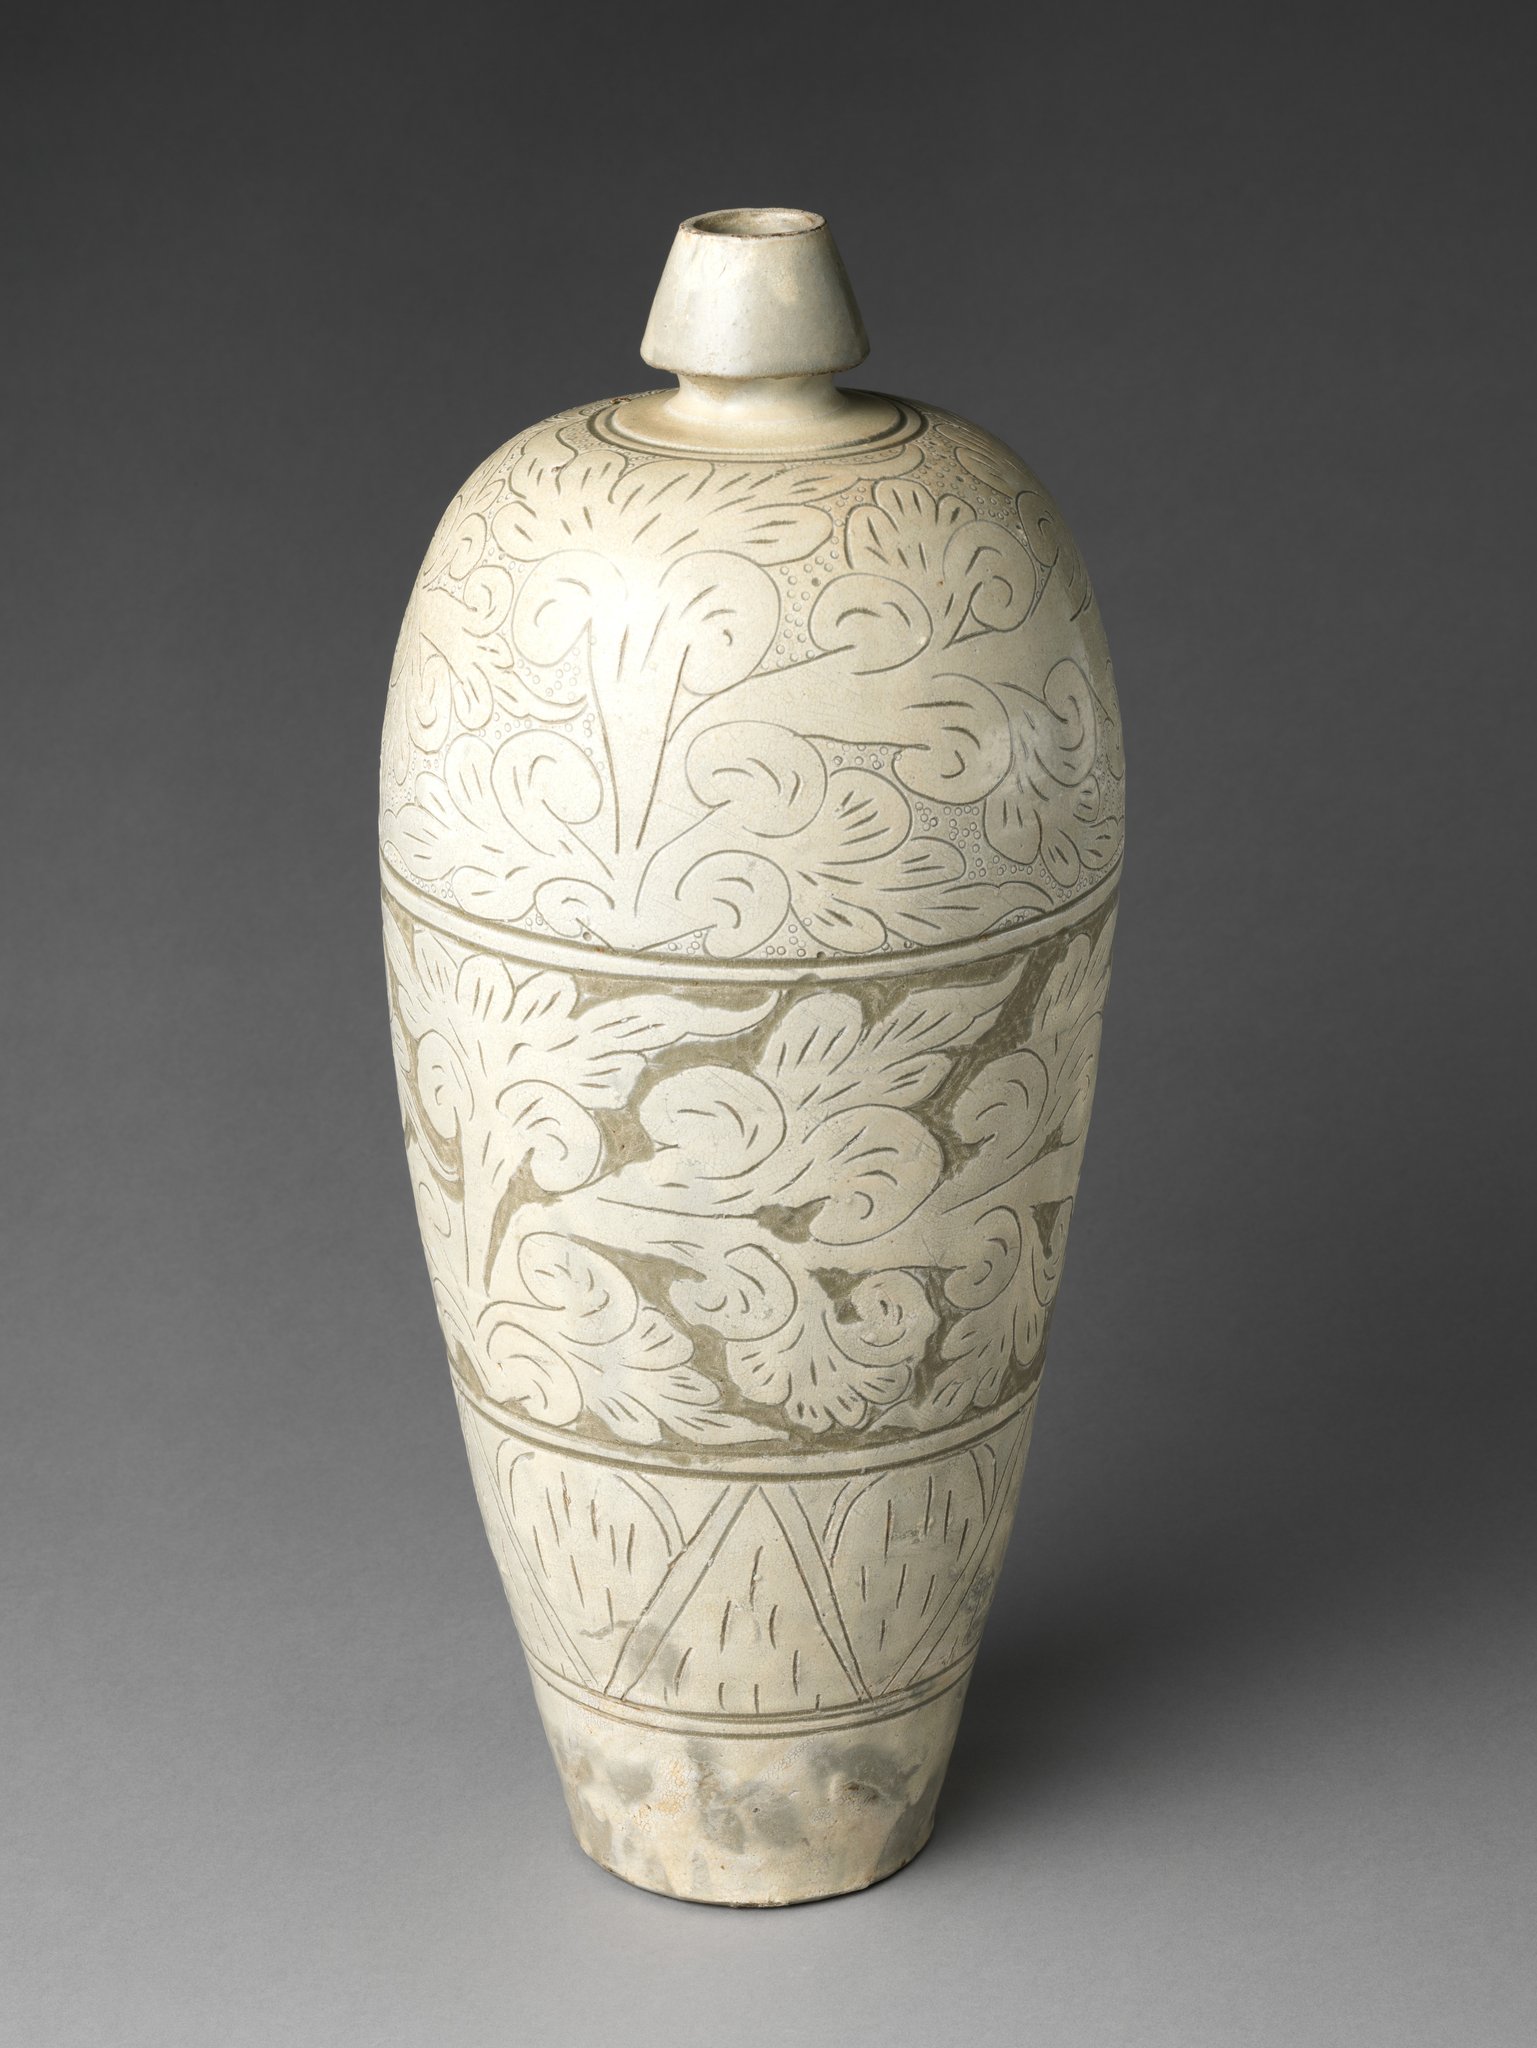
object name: vase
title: Vase with abstract scroll decoration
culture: chinese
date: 1001-1200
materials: stoneware